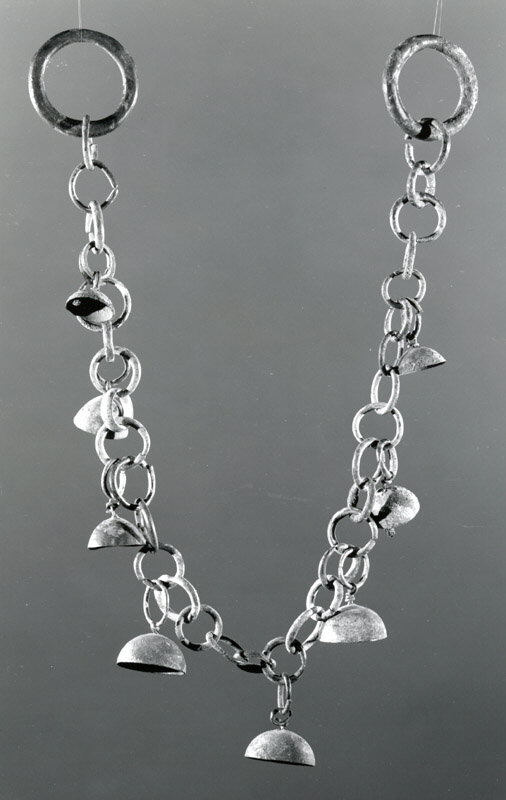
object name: bell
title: Bells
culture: iranian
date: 1000-1 BCE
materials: bronze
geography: iran